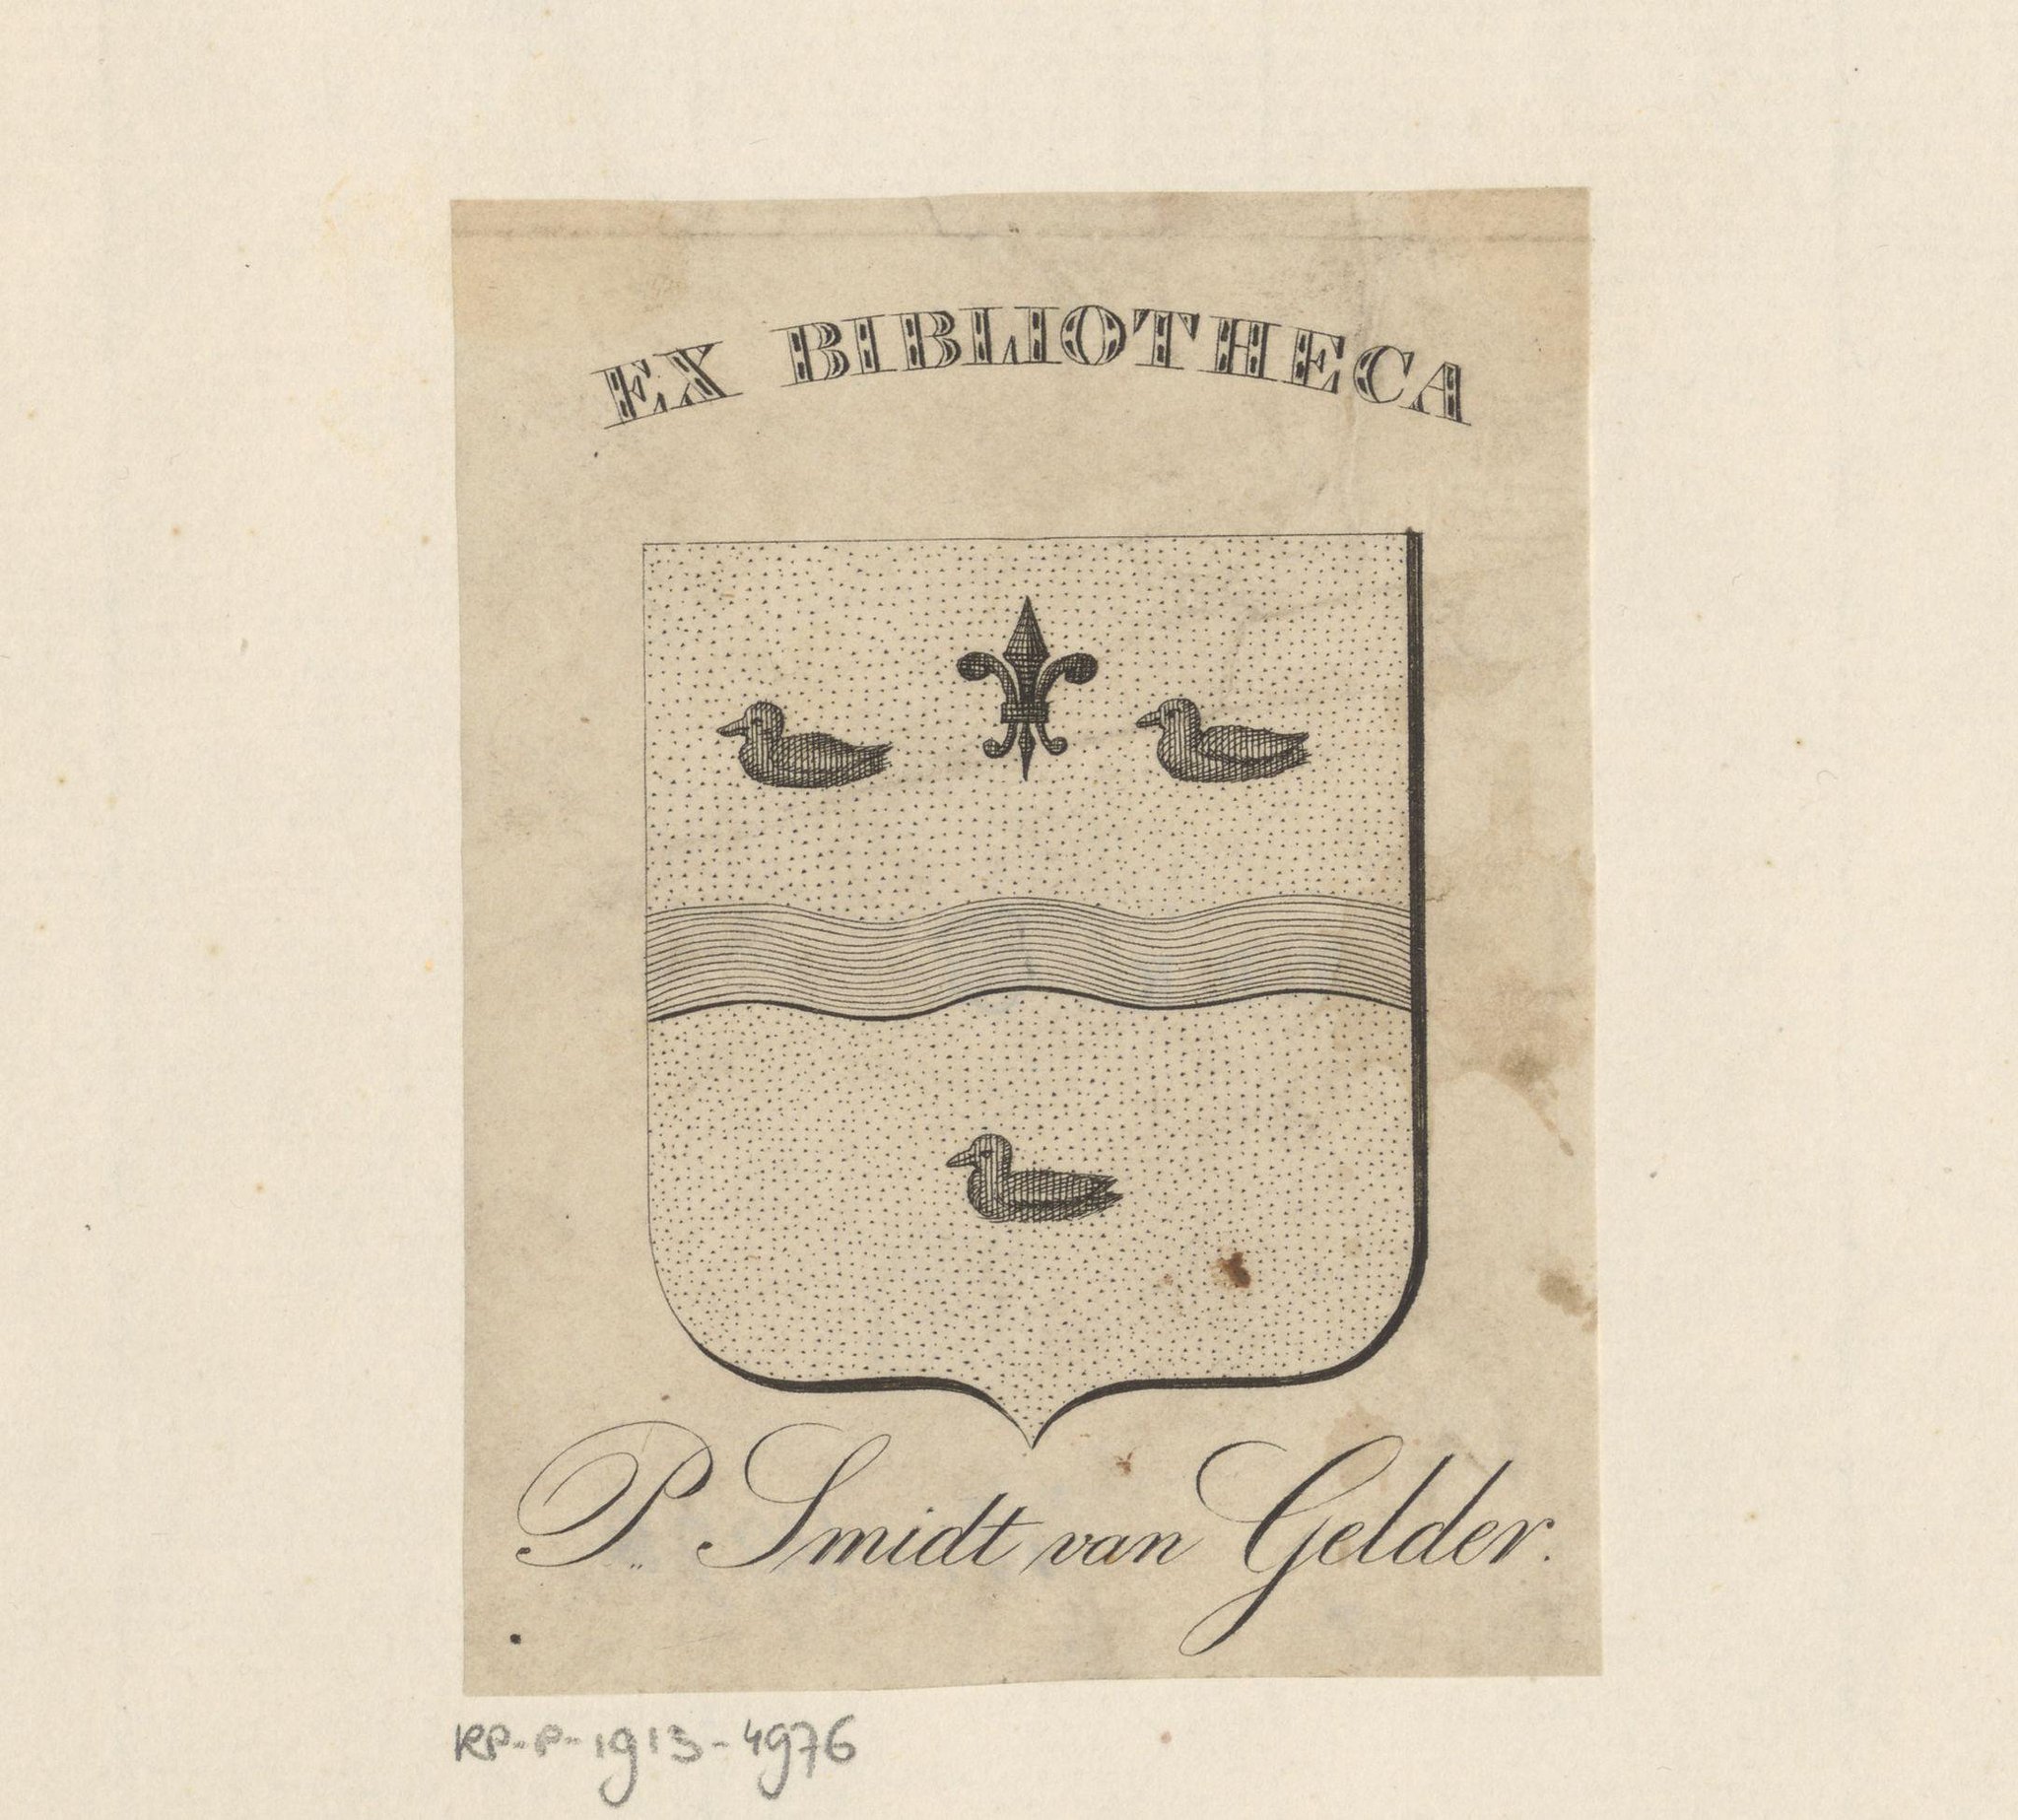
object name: bookplate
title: Ex libris van P. Smidt van Gelder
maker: Anonymous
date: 1888-1913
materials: paper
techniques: etching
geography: netherlands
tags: water-birds: duck, armorial bearing, heraldry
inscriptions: collector's mark: Lugt 2760, collector's mark: Lugt 2233